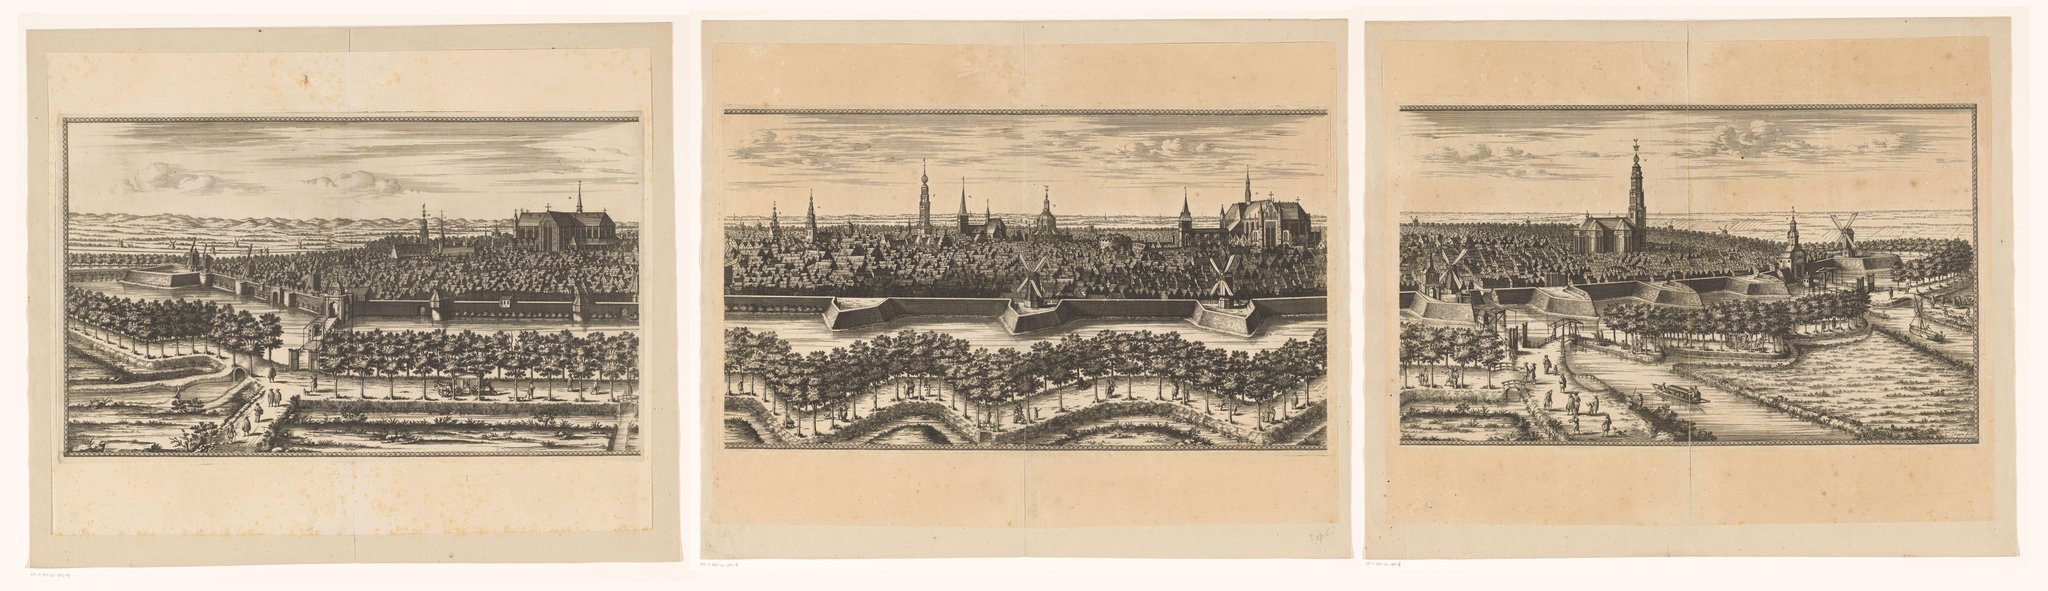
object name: print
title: Profiel van Leiden, bestaande uit drie delen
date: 1675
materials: paper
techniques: engraving, etching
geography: amsterdam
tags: prospect of city, town panorama, silhouette of city, leiden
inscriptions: check stamp: ‘Archief Ministerie van Oorlog Afdeeling Genie’, collector's mark: Lugt 2228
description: Dit object is omwille van een betere presentatie virtueel samengevoegd maar bestaat fysiek uit losse onderdelen. Dit geheel vormt de onderkant van de rand van de zogenaamde Grote Hagen, een wandkaart van Leiden uit 1675. Deze wandkaart bestaat uit een plattegrond van Leiden met daaromheen een rand (met boven de titel en de wapens van de stad en de burgemeesters, langs de zijkanten afbeeldingen van gebouwen in de stad en onder een stadsprofiel). De plattegrond is gedrukt van vier platen, de rand van veertien. Hoewel het jaartal 1670 in de titel staat en de wapens aan de bovenkant van de vier in 1670 zittende burgemeesters zijn, blijkt uit archiefonderzoek dat deze wandkaart in 1675 pas voor het eerst is gedrukt en uitgegeven (zie documentatie voor meer informatie). Voor een digitaal gemonteerde versie van de hele rand zie RP-P-2016-1124. Voor een digitaal gemonteerde versie van de bovenkant van de rand zie RP-P-AO-10-18A-A. Voor een digitaal gemonteerde versie van een latere druk van de plattegrond zie RP-P-AO-10-18. Voor een digitaal gemonteerde versie van de Kleine Hagen zie RP-P-AO-10-81.